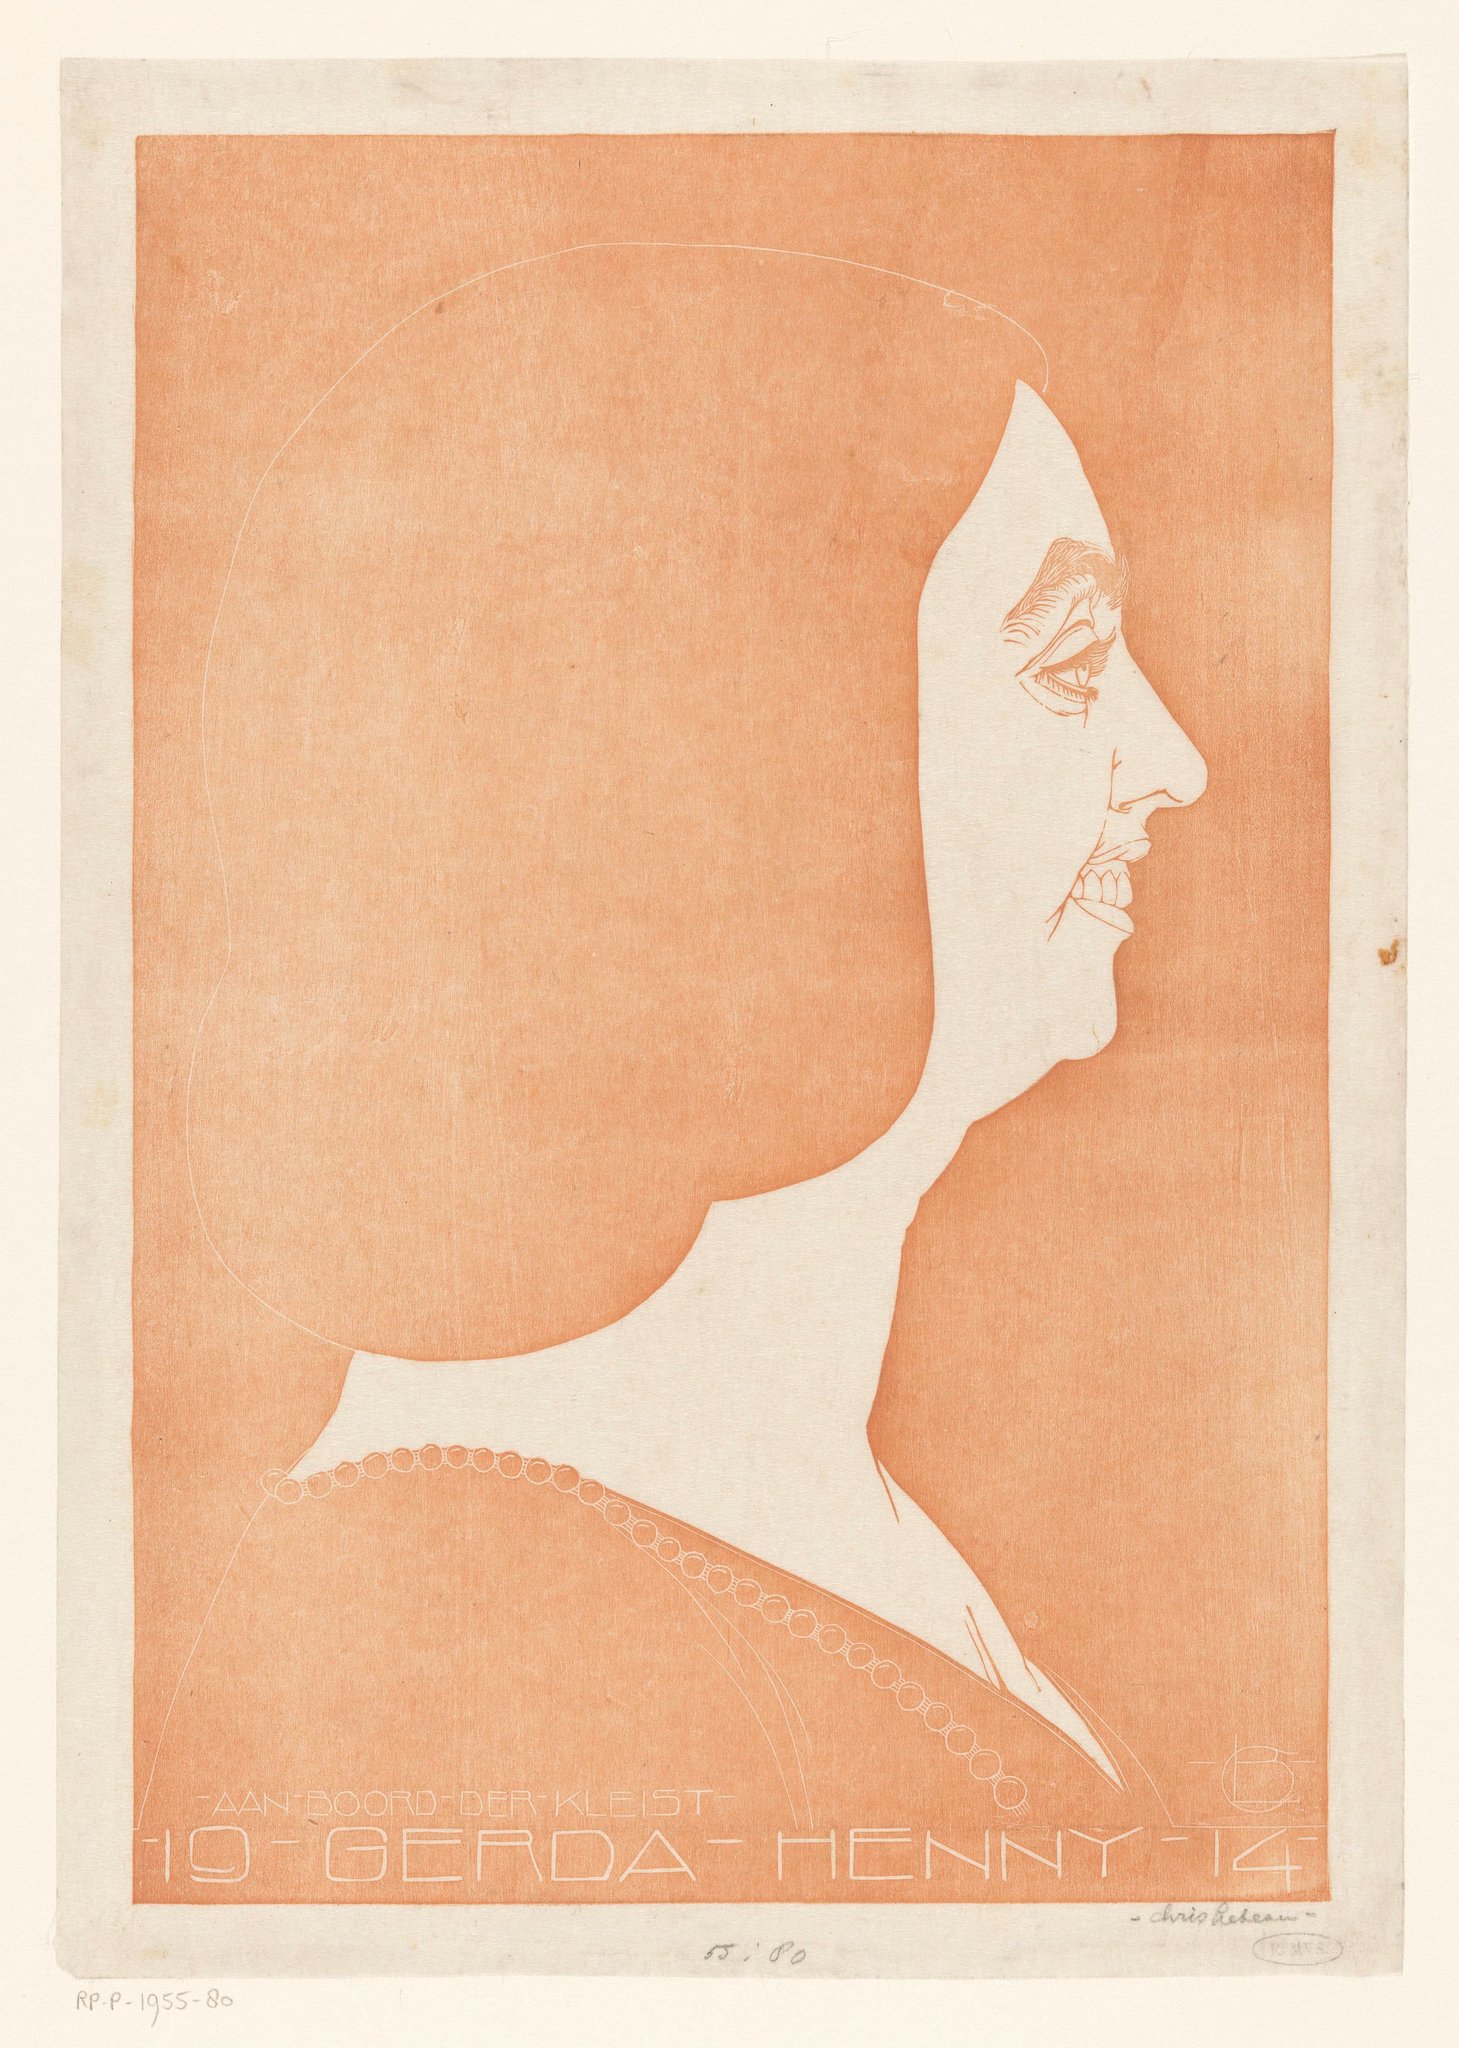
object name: print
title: Portret van Gerda Henny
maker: chris lebeau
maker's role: draughtsman, print maker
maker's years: 1878-1945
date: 1914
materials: paper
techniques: woodcut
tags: gerda henny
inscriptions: collector's mark: Lugt 2228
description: Haar bovenlip is omhoog gekruld waardoor haar tanden te zien zijn. Onderaan de tekst 'aan boord der kleist'.